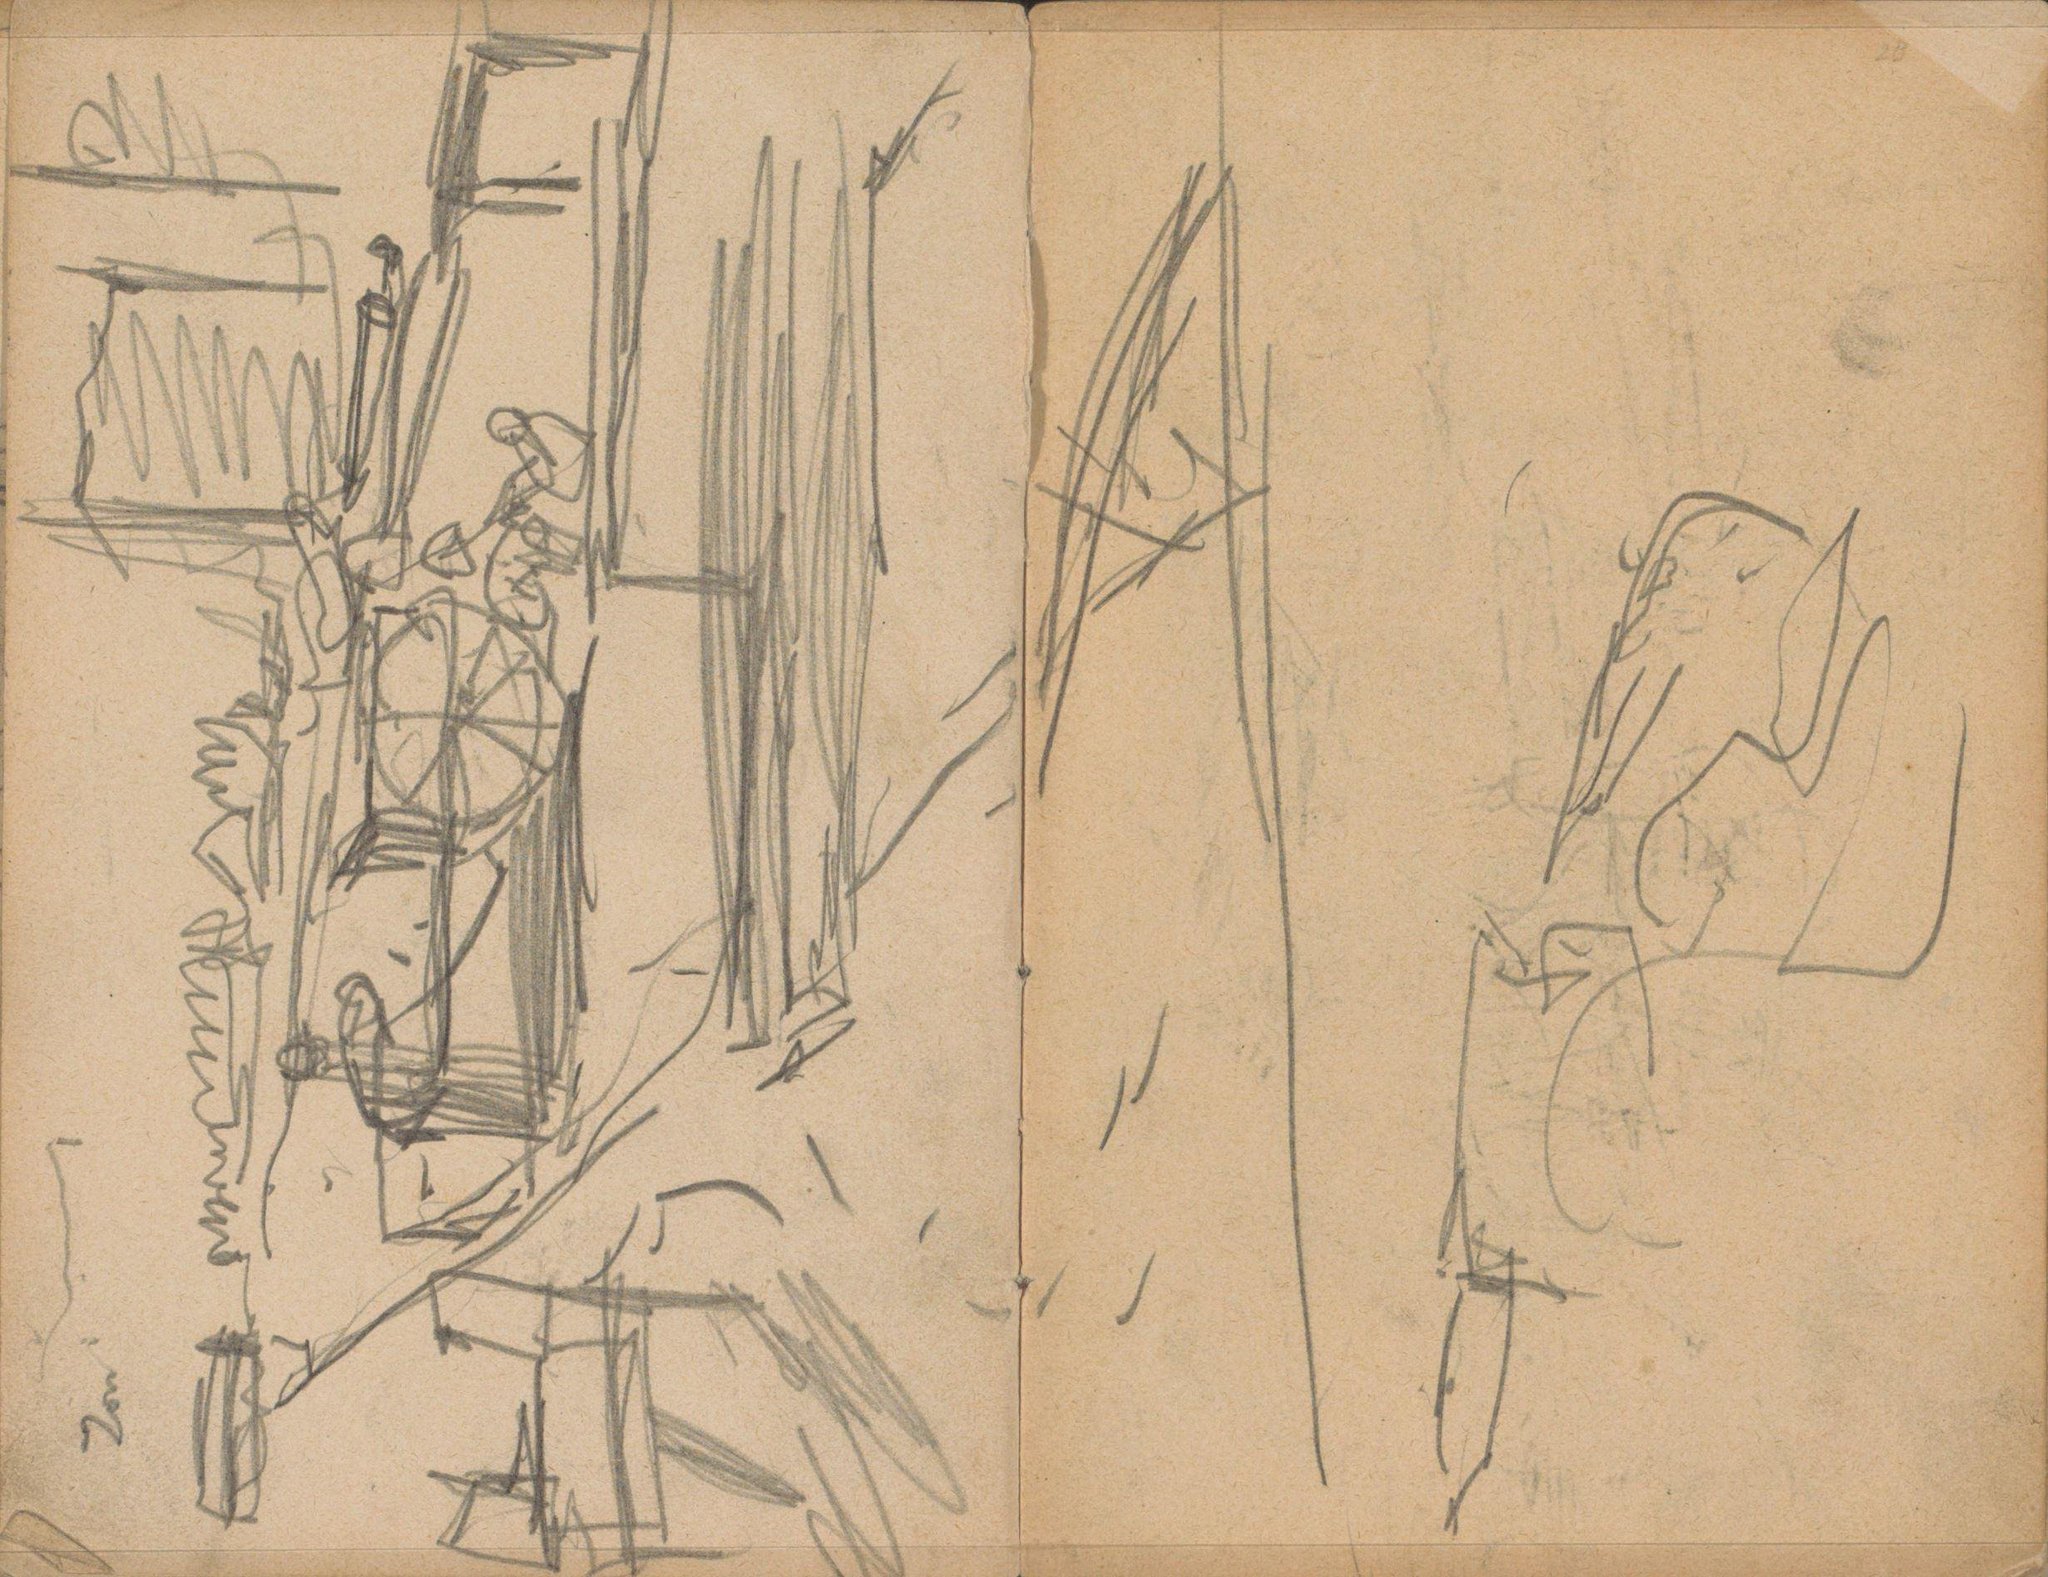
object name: sketchbook leaf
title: Kruiers op de Overtoom te Amsterdam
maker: george hendrik breitner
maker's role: draughtsman, painter, print maker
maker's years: 1857-1923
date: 1900-1901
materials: paper, pencil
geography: amsterdam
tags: canals, waters (in city), porter, bearer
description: Kruiers op de Overtoom te Amsterdam. Pagina 27 en pagina 28 uit een schetsboek met 46 bladen vervaardigd te Amsterdam.